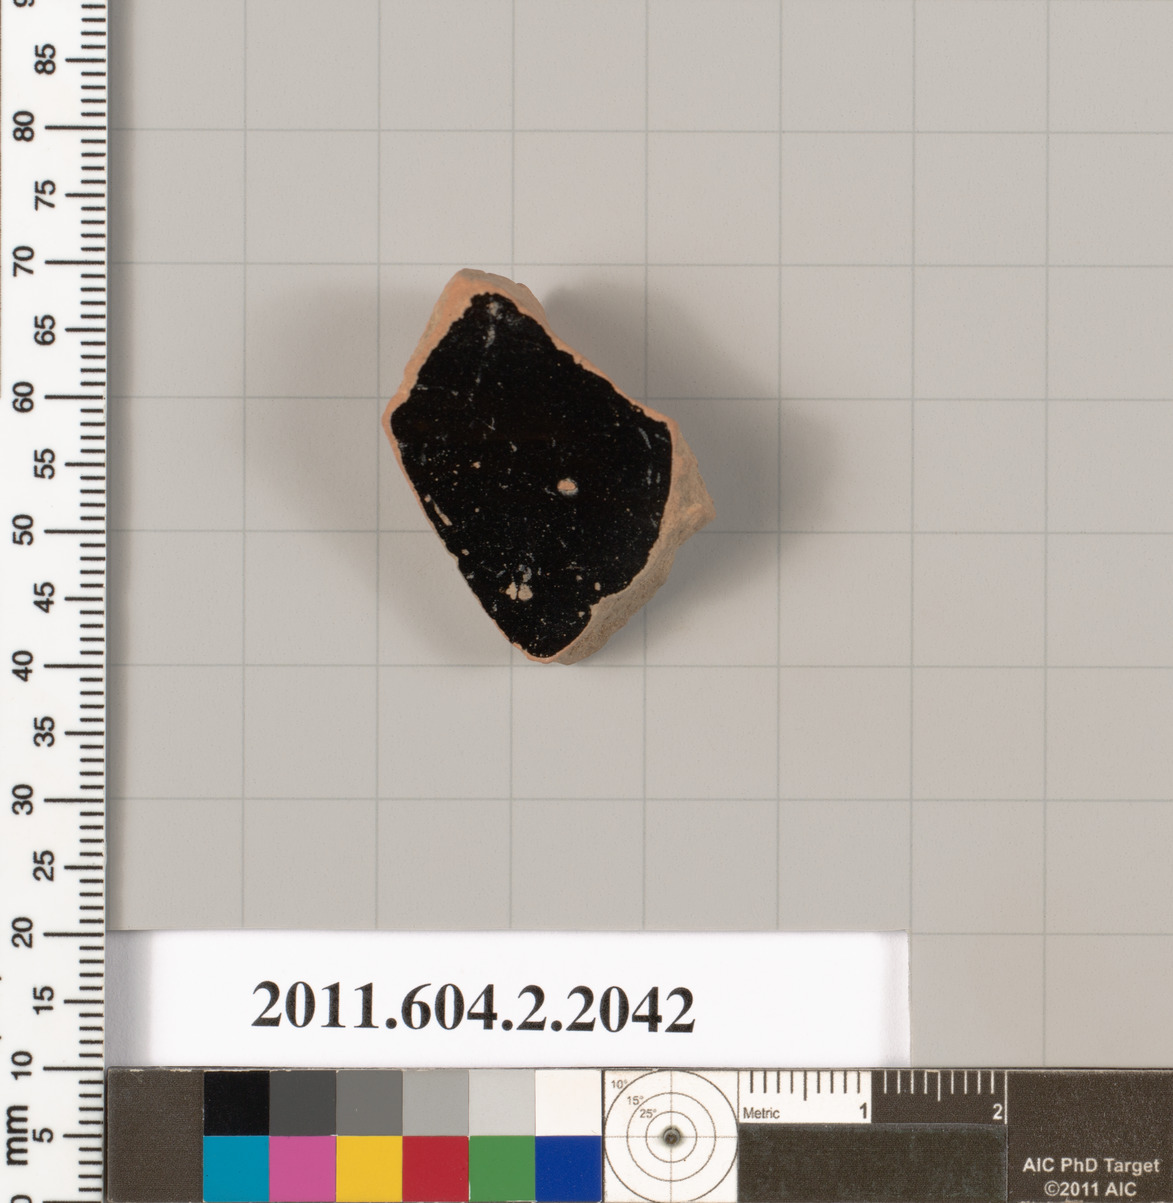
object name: skyphos fragment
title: Terracotta fragment of a skyphos (deep drinking cup)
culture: greek, attic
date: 500-401 BCE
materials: terracotta